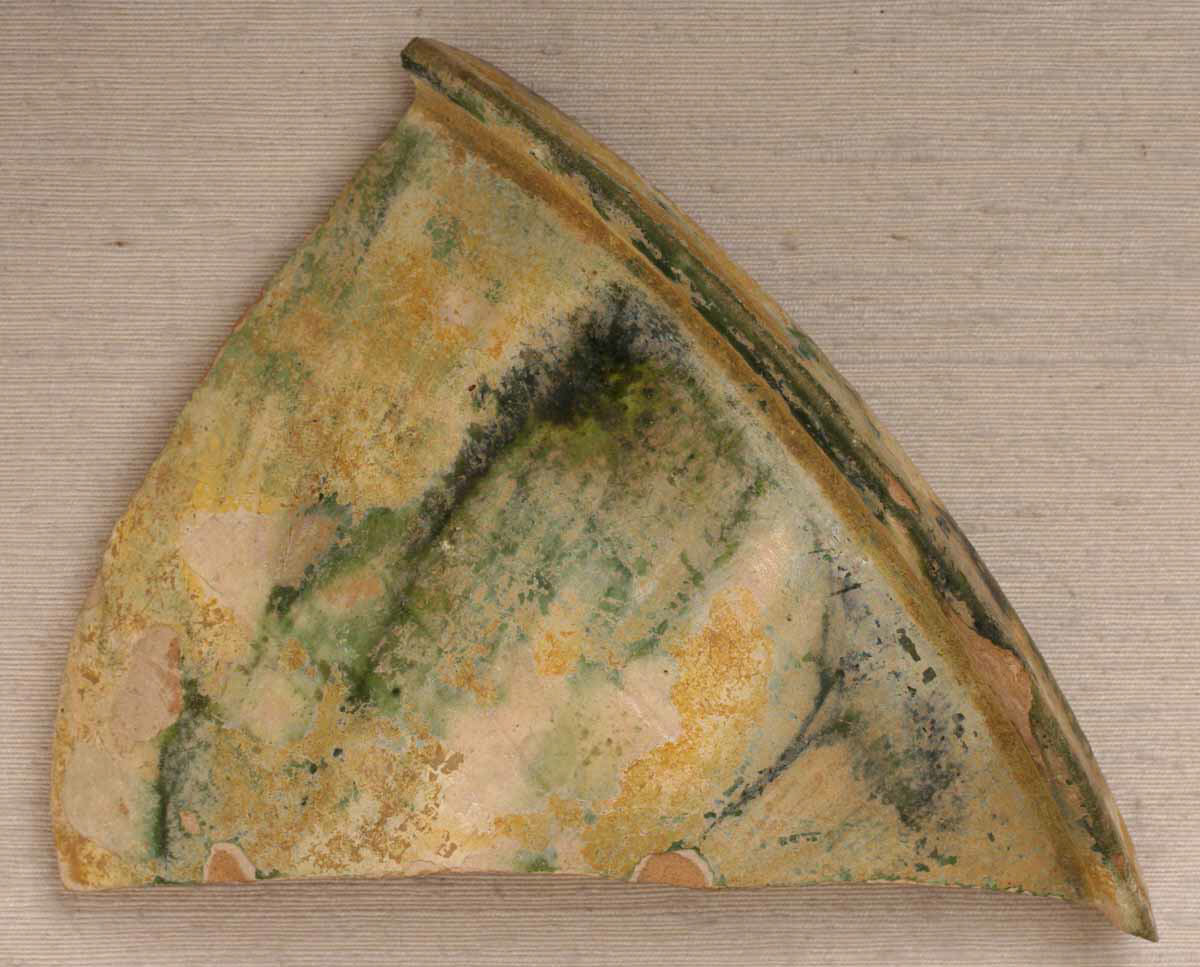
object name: fragment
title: Fragments of Splashed Ceramic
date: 801-900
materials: earthenware, glaze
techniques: painting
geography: iraq